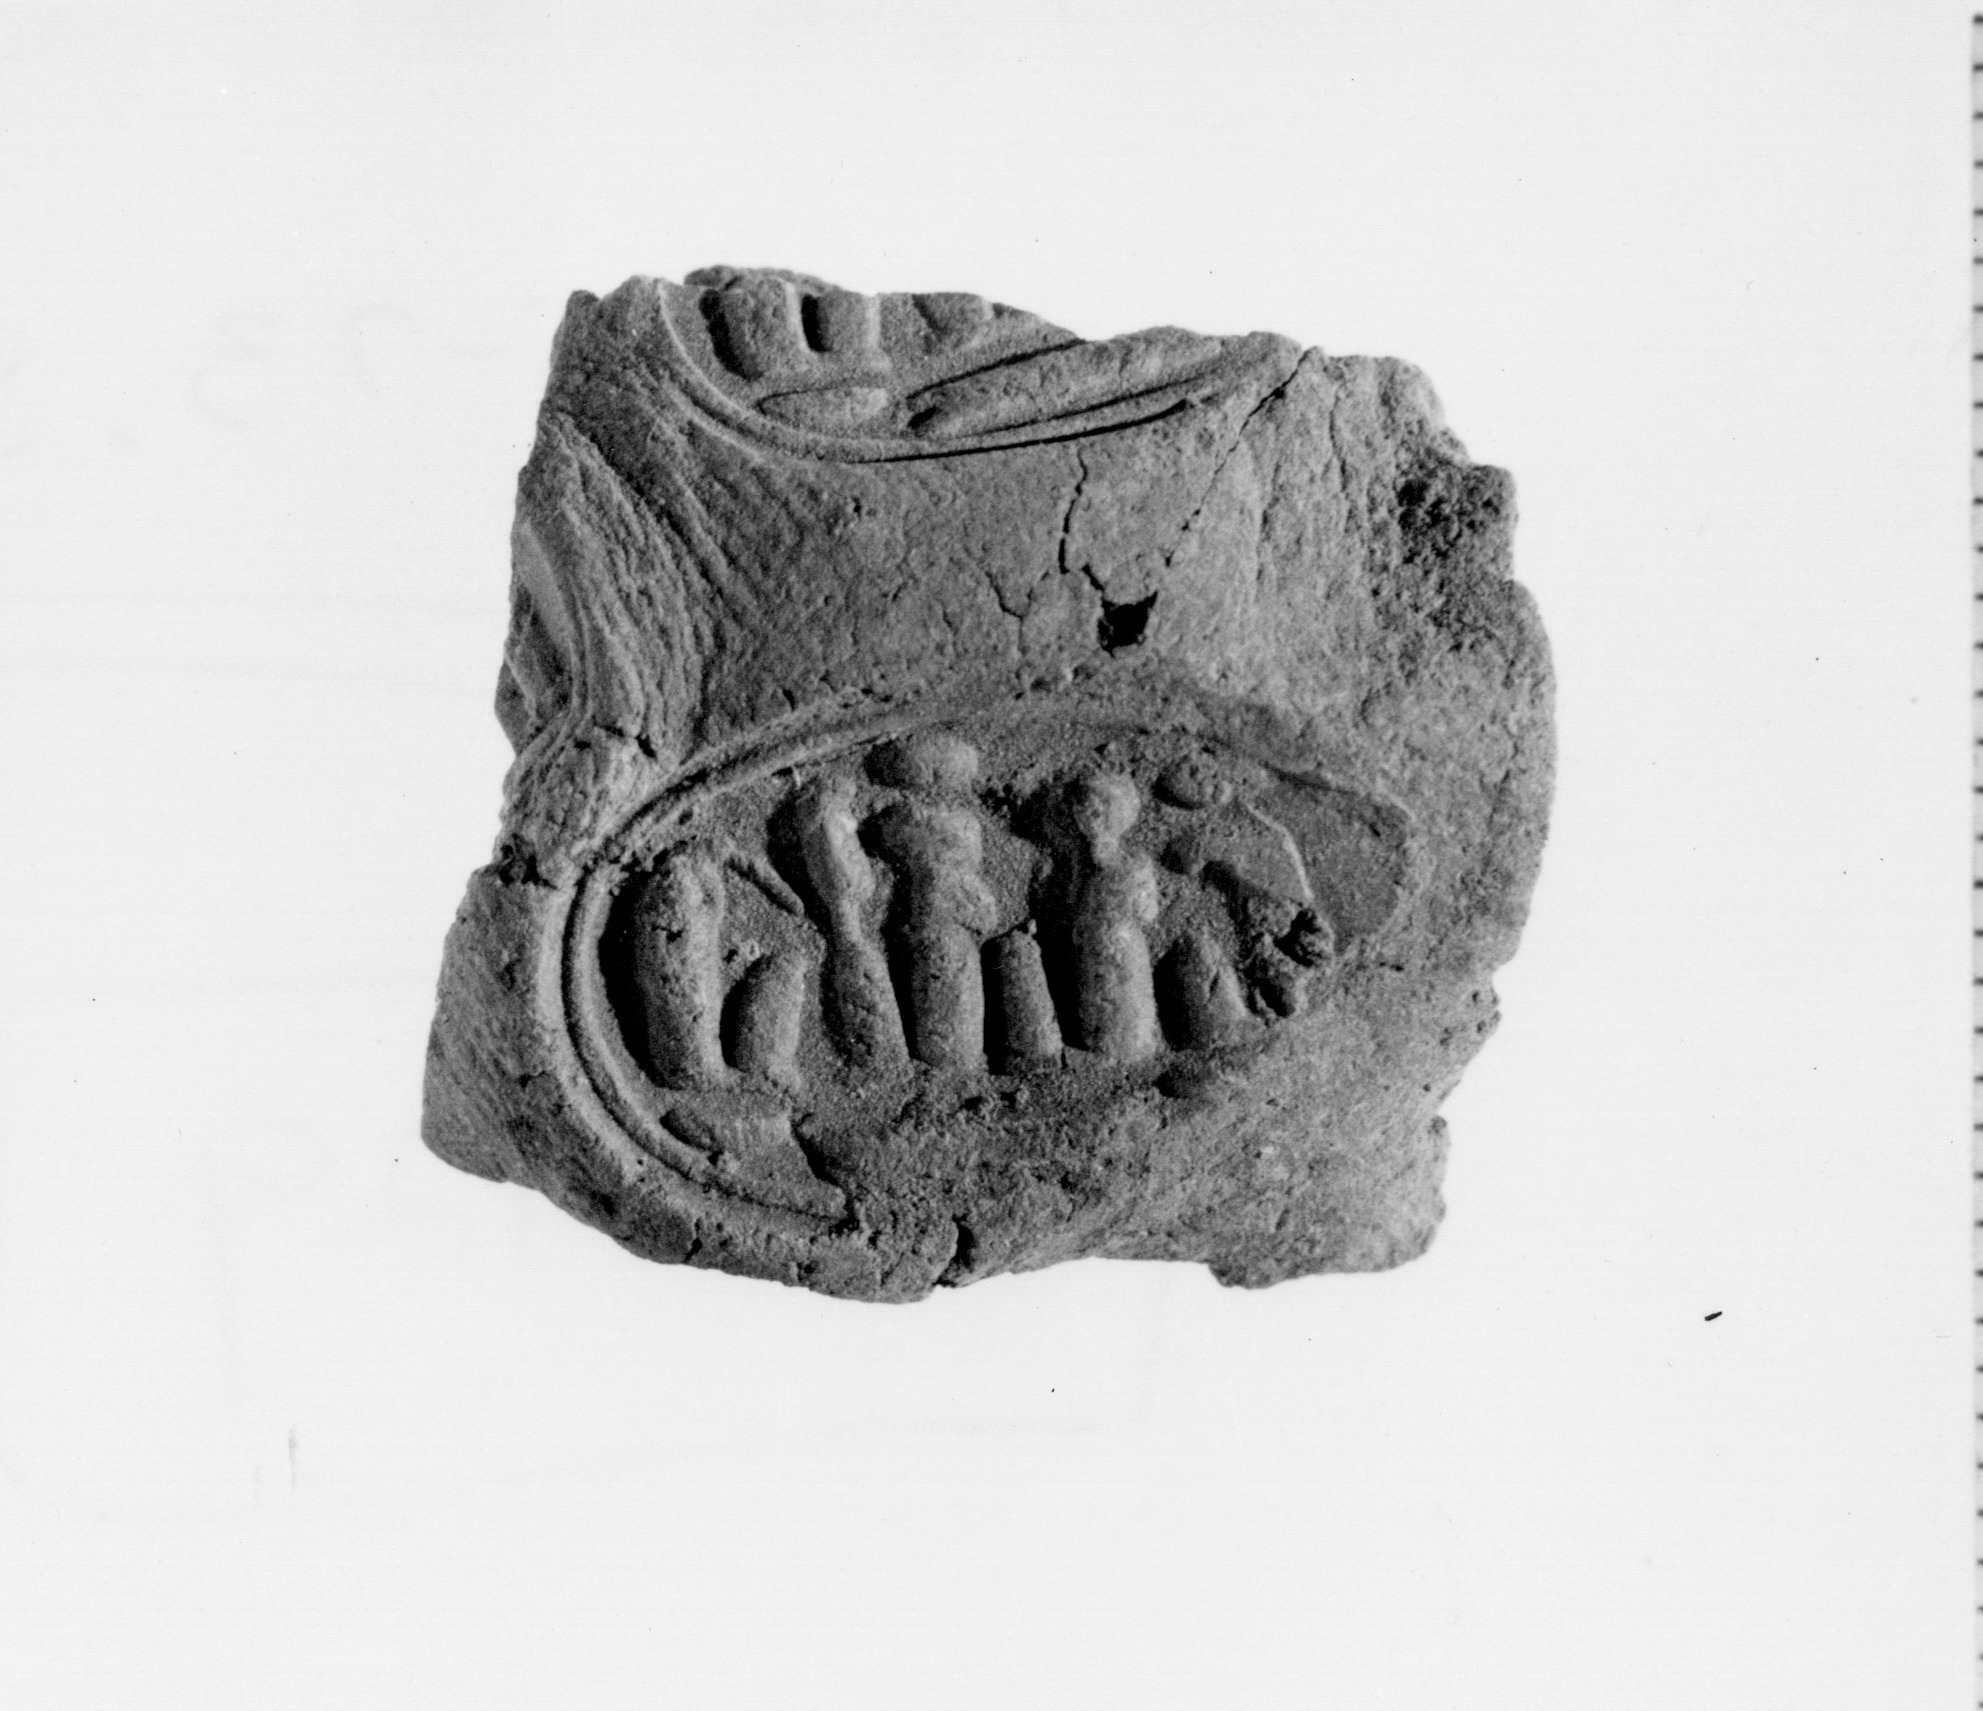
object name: sealing, nebmaatre, amenhotep iii, thoth, ptah, sakhmet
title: Document Sealing With the Throne Name of Amenhotep III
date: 1390-1352 BCE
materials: mud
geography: egypt